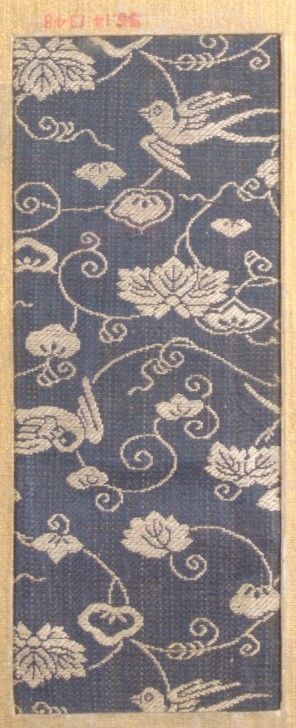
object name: piece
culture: japanese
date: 1701-1900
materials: silk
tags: leaves